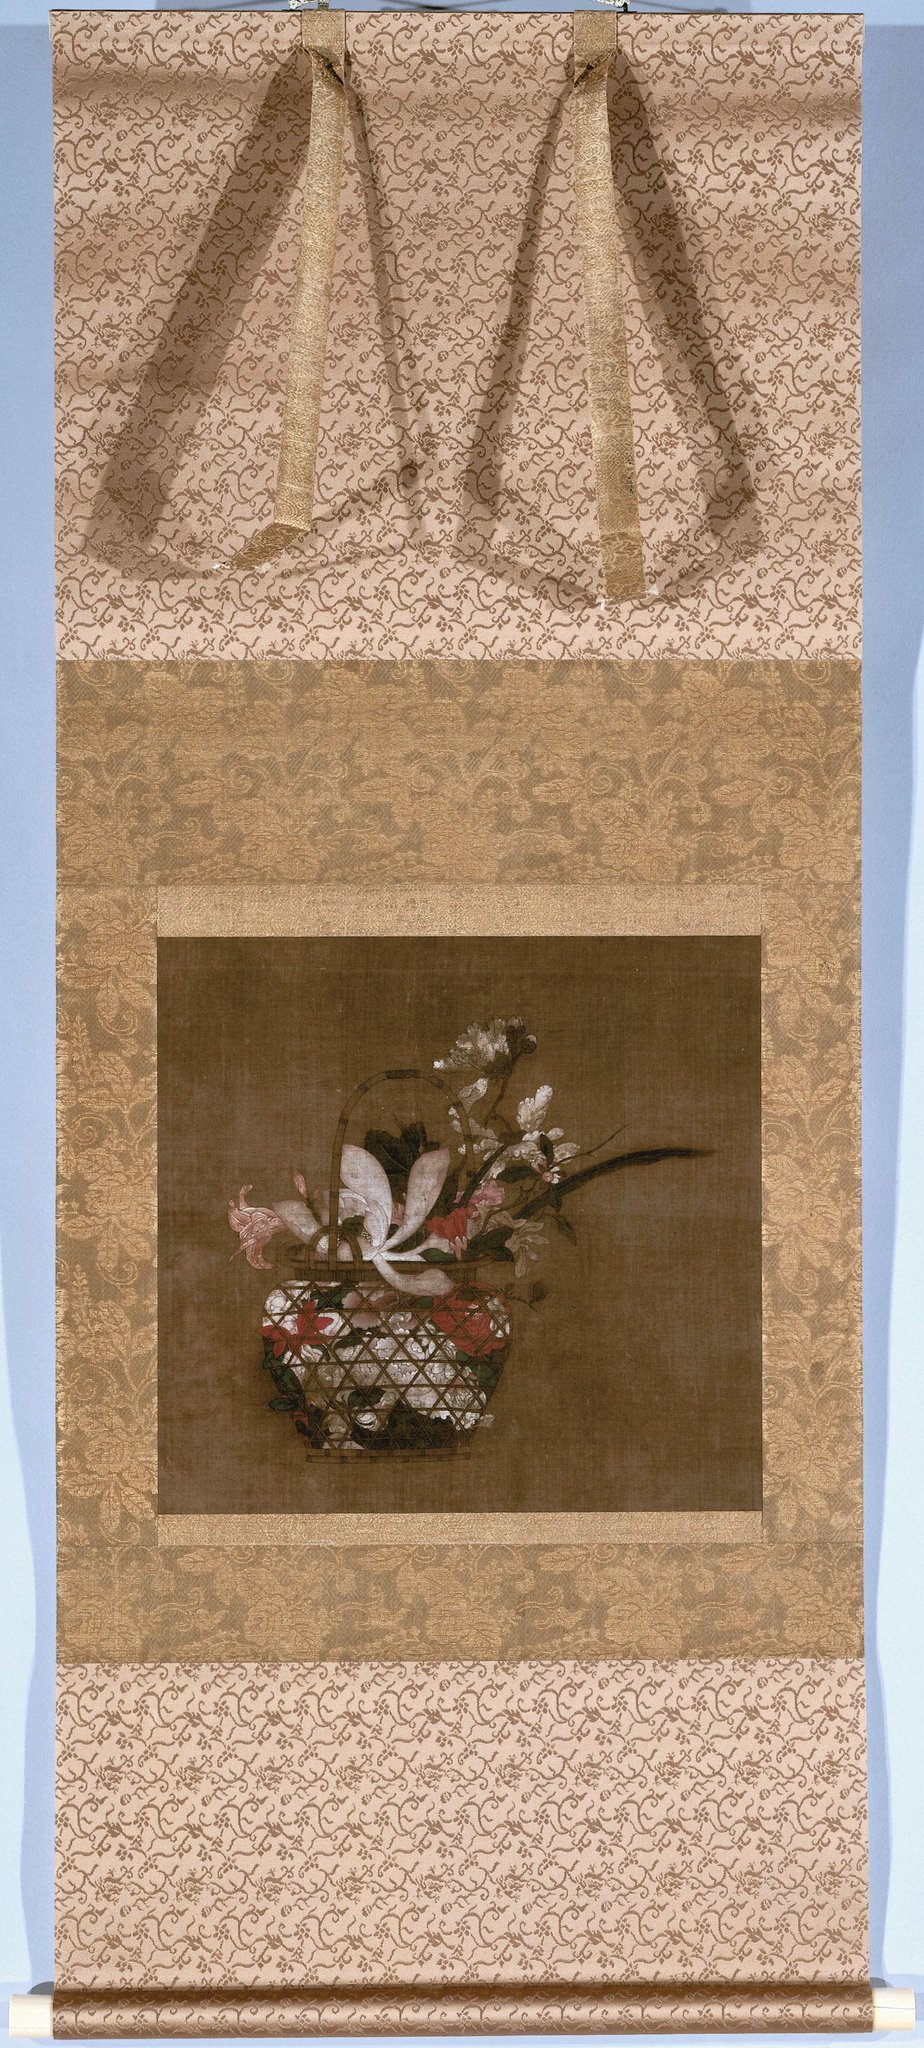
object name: hanging scroll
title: Rolschildering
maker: Anonymous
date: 1368-1644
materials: dye, ink, silk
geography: china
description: Basket with flowers. China. 16th century. Colours with ink on silk.